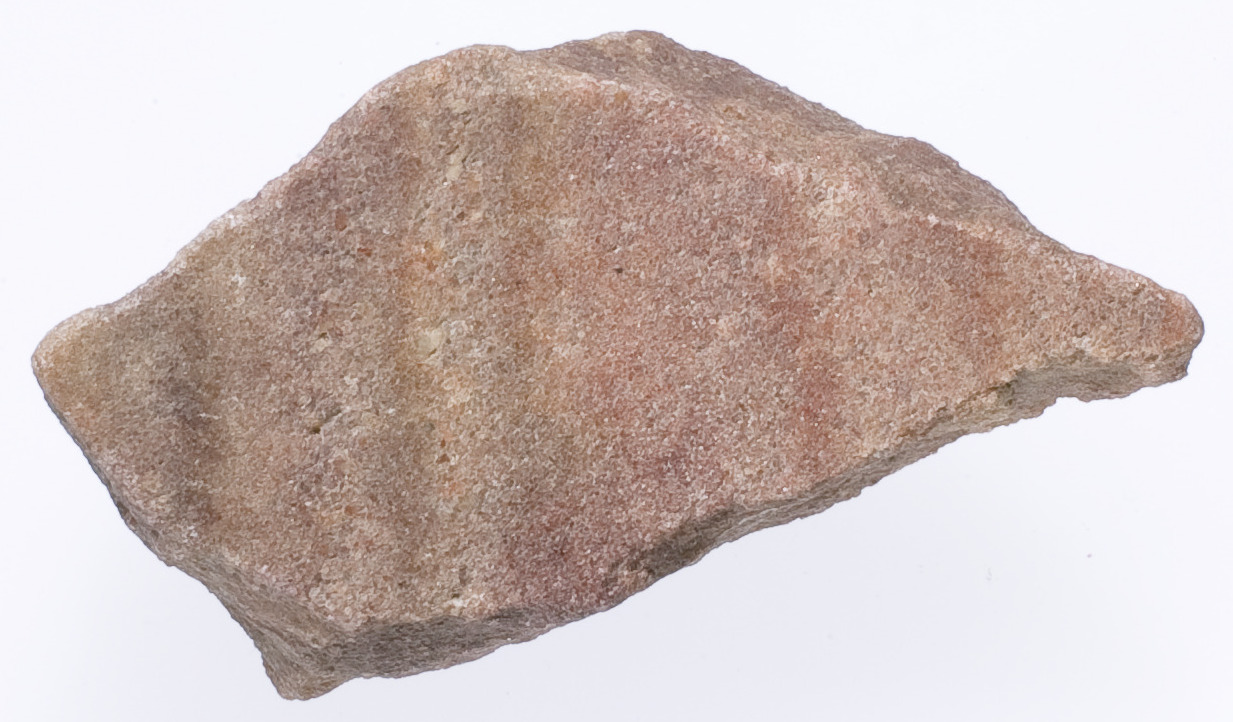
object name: pleat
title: faint pleats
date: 1353-1336 BCE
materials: quartzite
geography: egypt